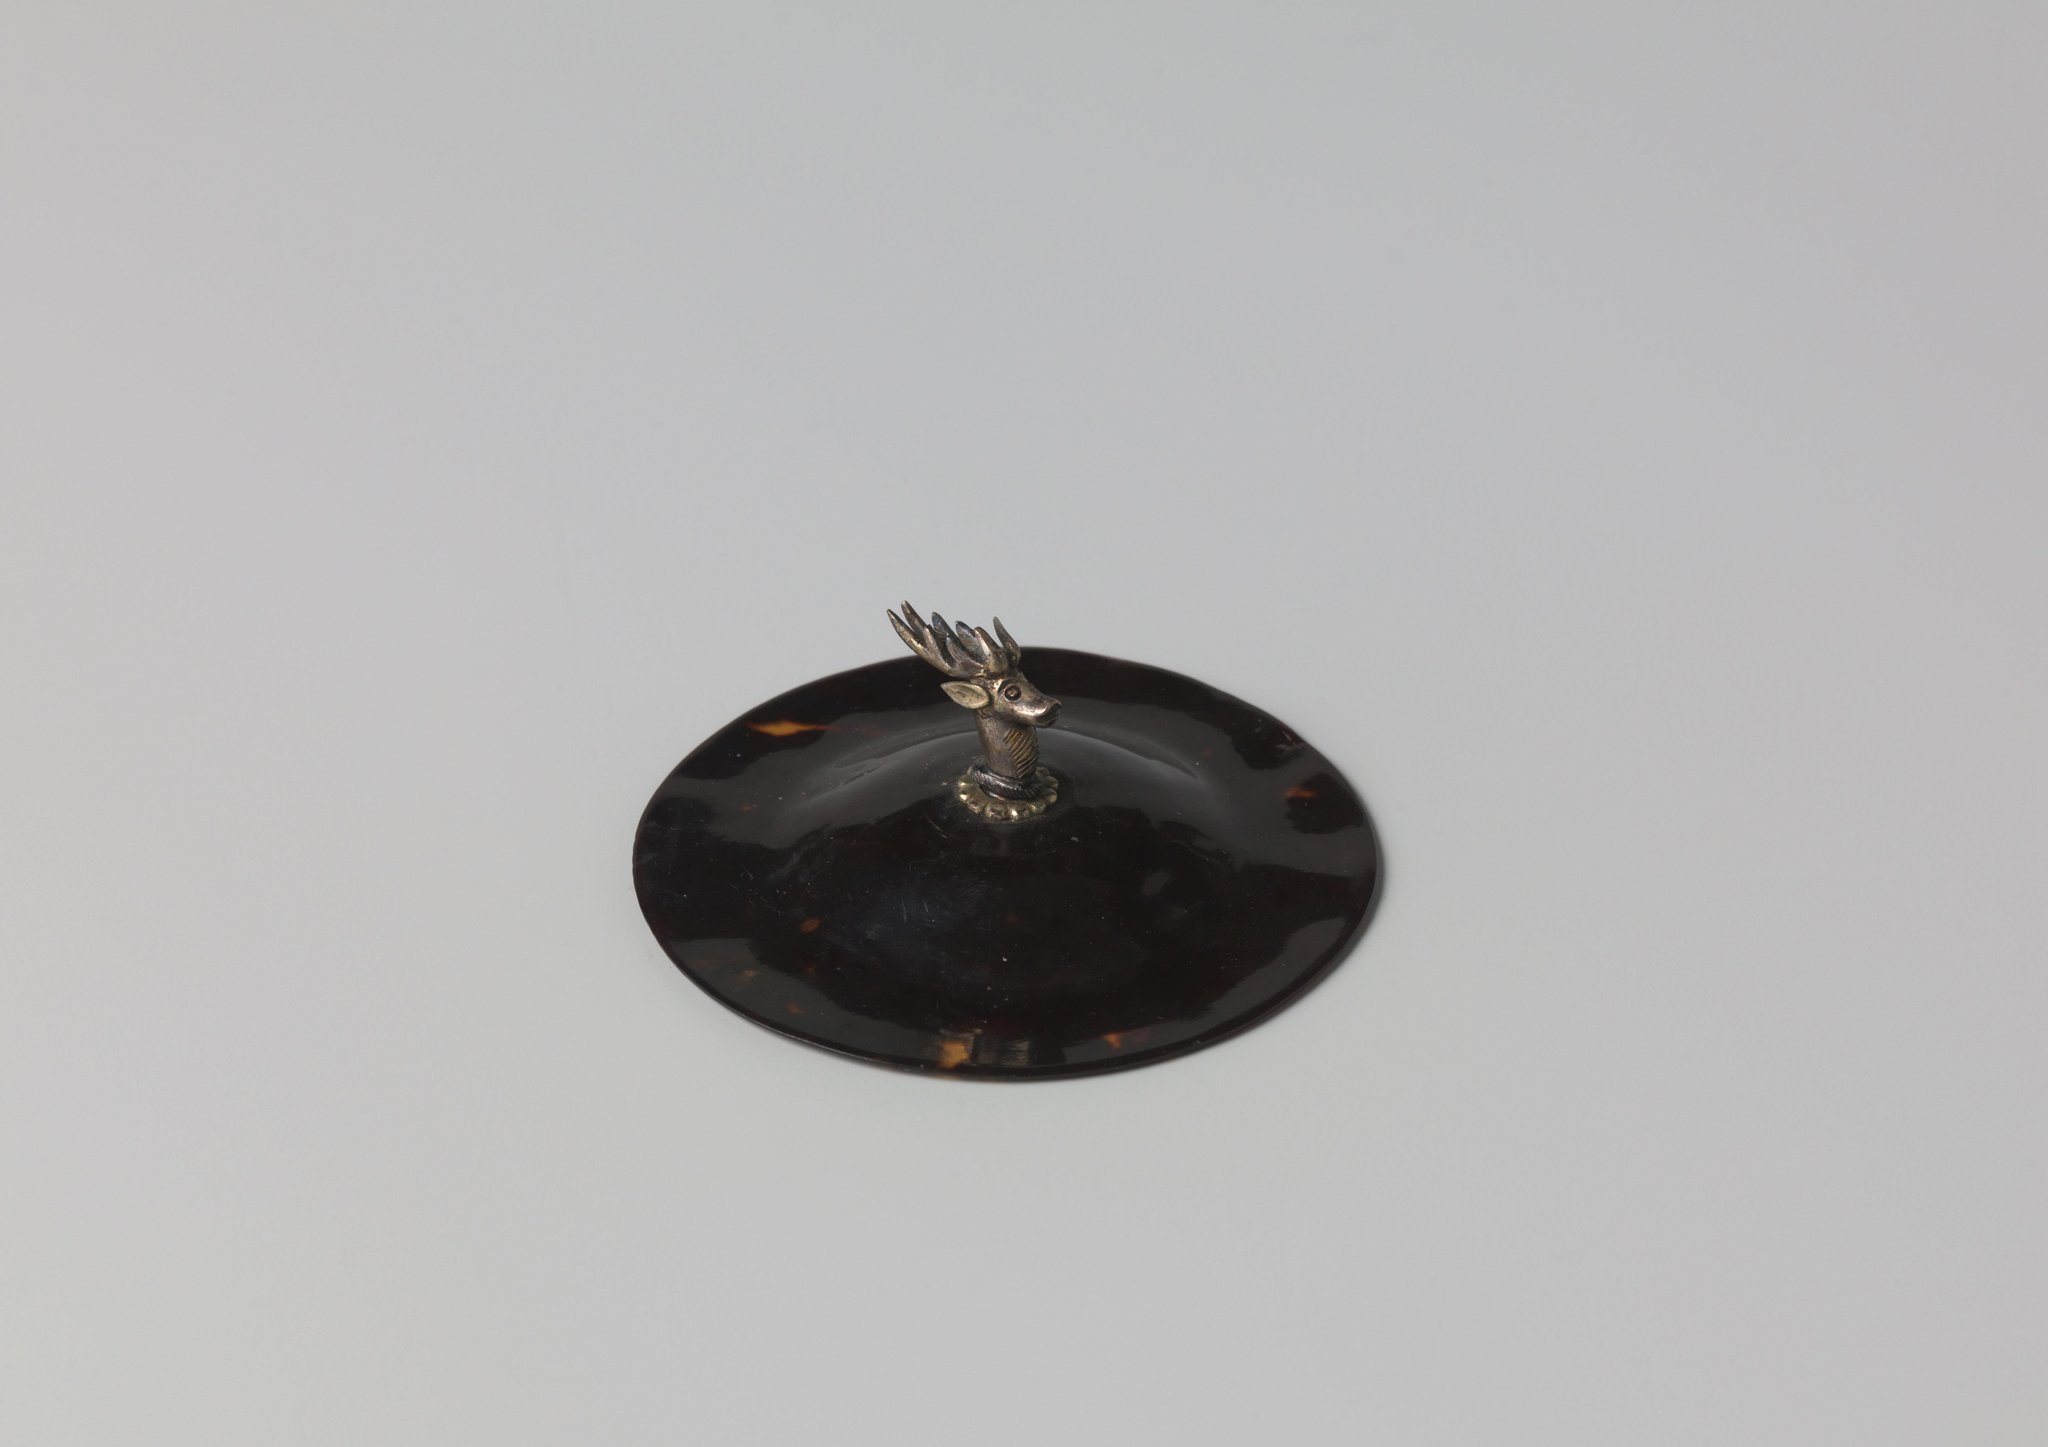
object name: lid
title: Deksel van schildpad met hertekop van zilver (serie van 28 stuks A t/m BB)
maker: Anonymous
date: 1700-1799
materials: silver, shell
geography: indonesia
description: Deksel van schildpad met hertekop van zilver (serie van 28 stuks A t/m BB), Indonesië, 18de eeuw?